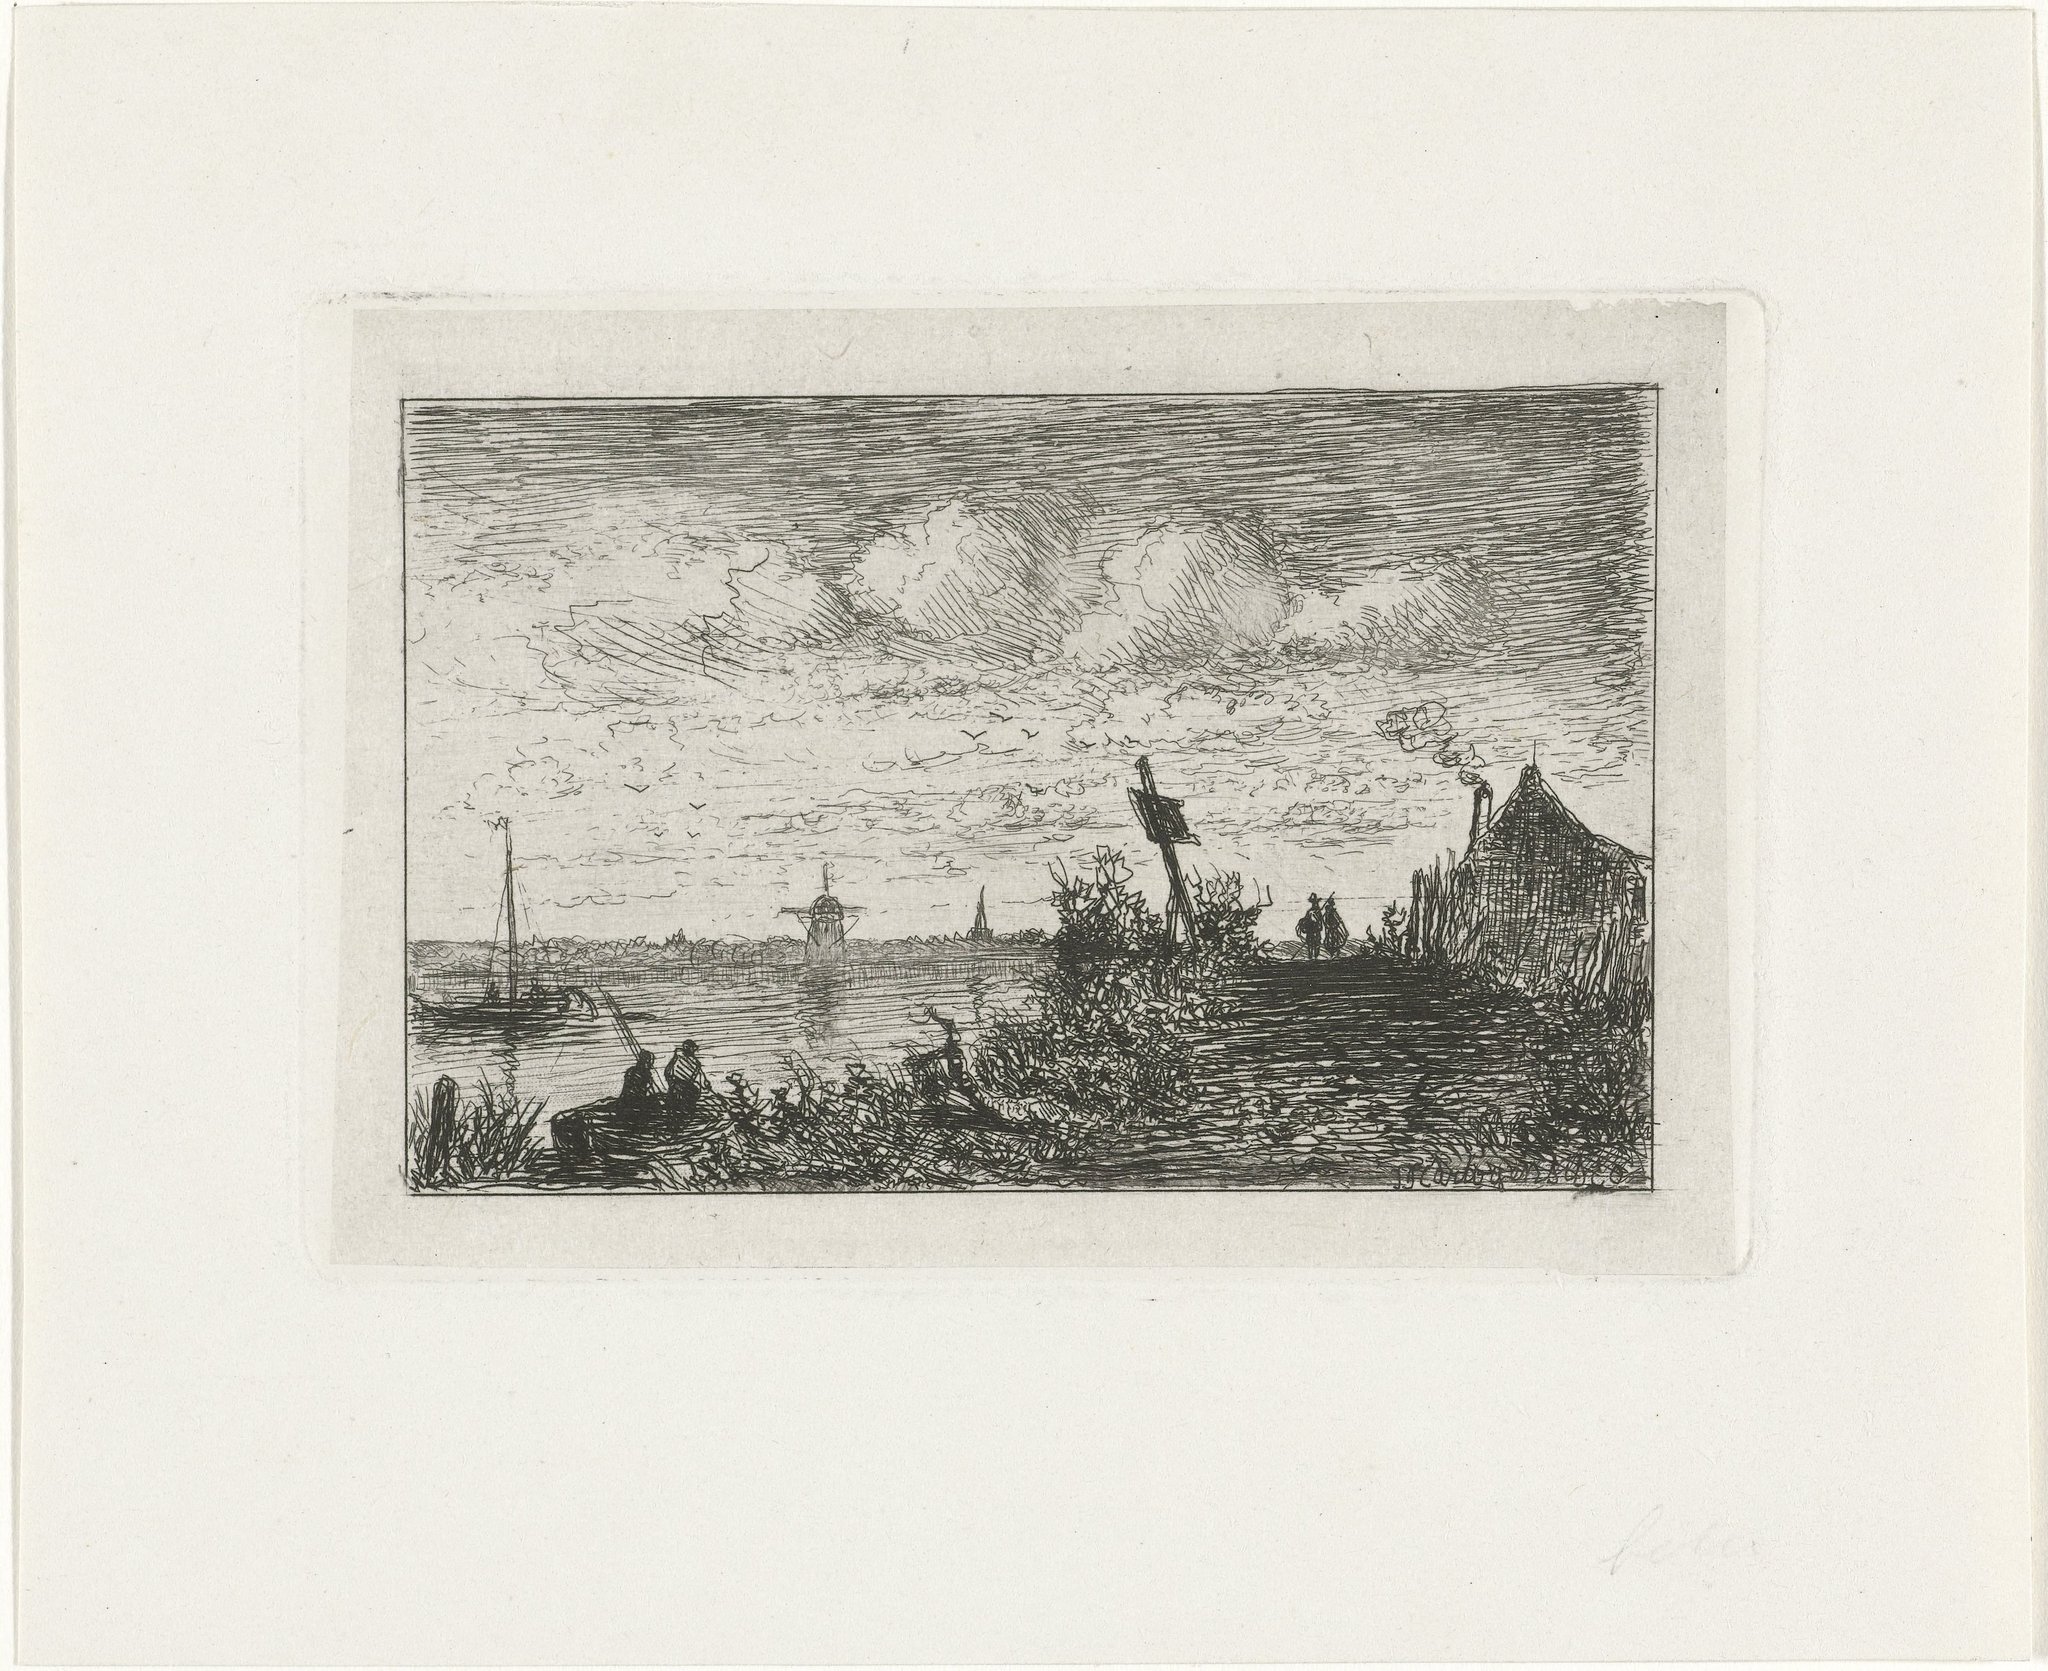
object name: print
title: Weg langs een rivier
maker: joseph hartogensis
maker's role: painter, print maker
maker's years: 1822-1865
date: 1850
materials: paper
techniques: etching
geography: dusseldorf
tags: landscapes with waters, waterscapes, seascapes (in the temperate zone) (+ landscape with figures, staffage), windmill in landscape (+ city(-scape) with figures, staffage)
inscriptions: collector's mark: Lugt 2228